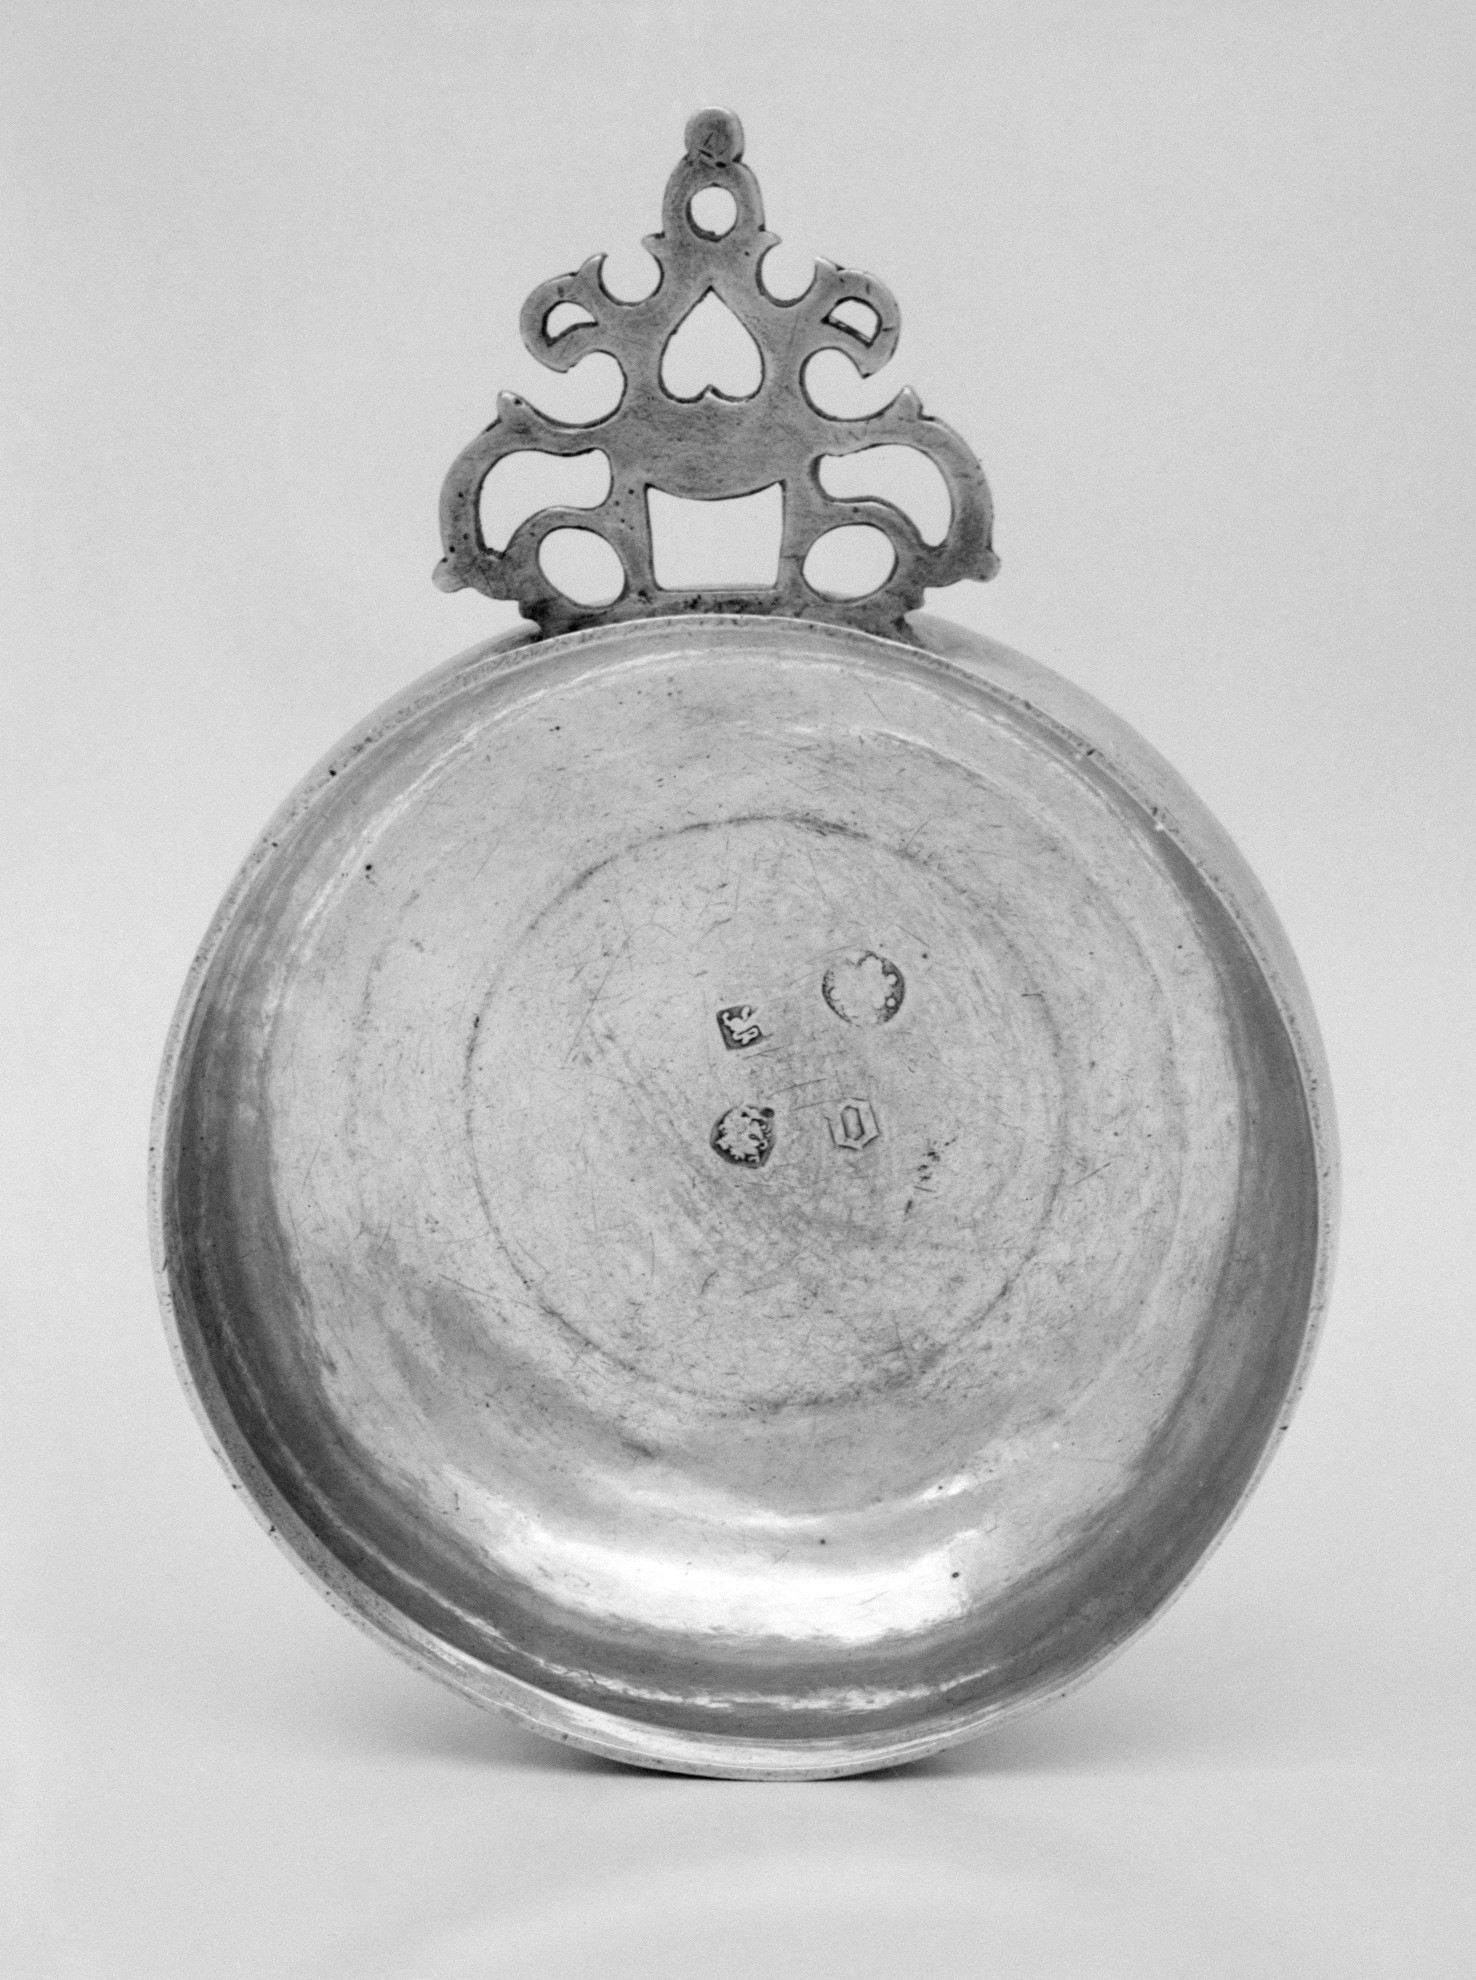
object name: porringer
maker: timothy ley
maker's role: maker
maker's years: 1690-1692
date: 1691-1692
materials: silver